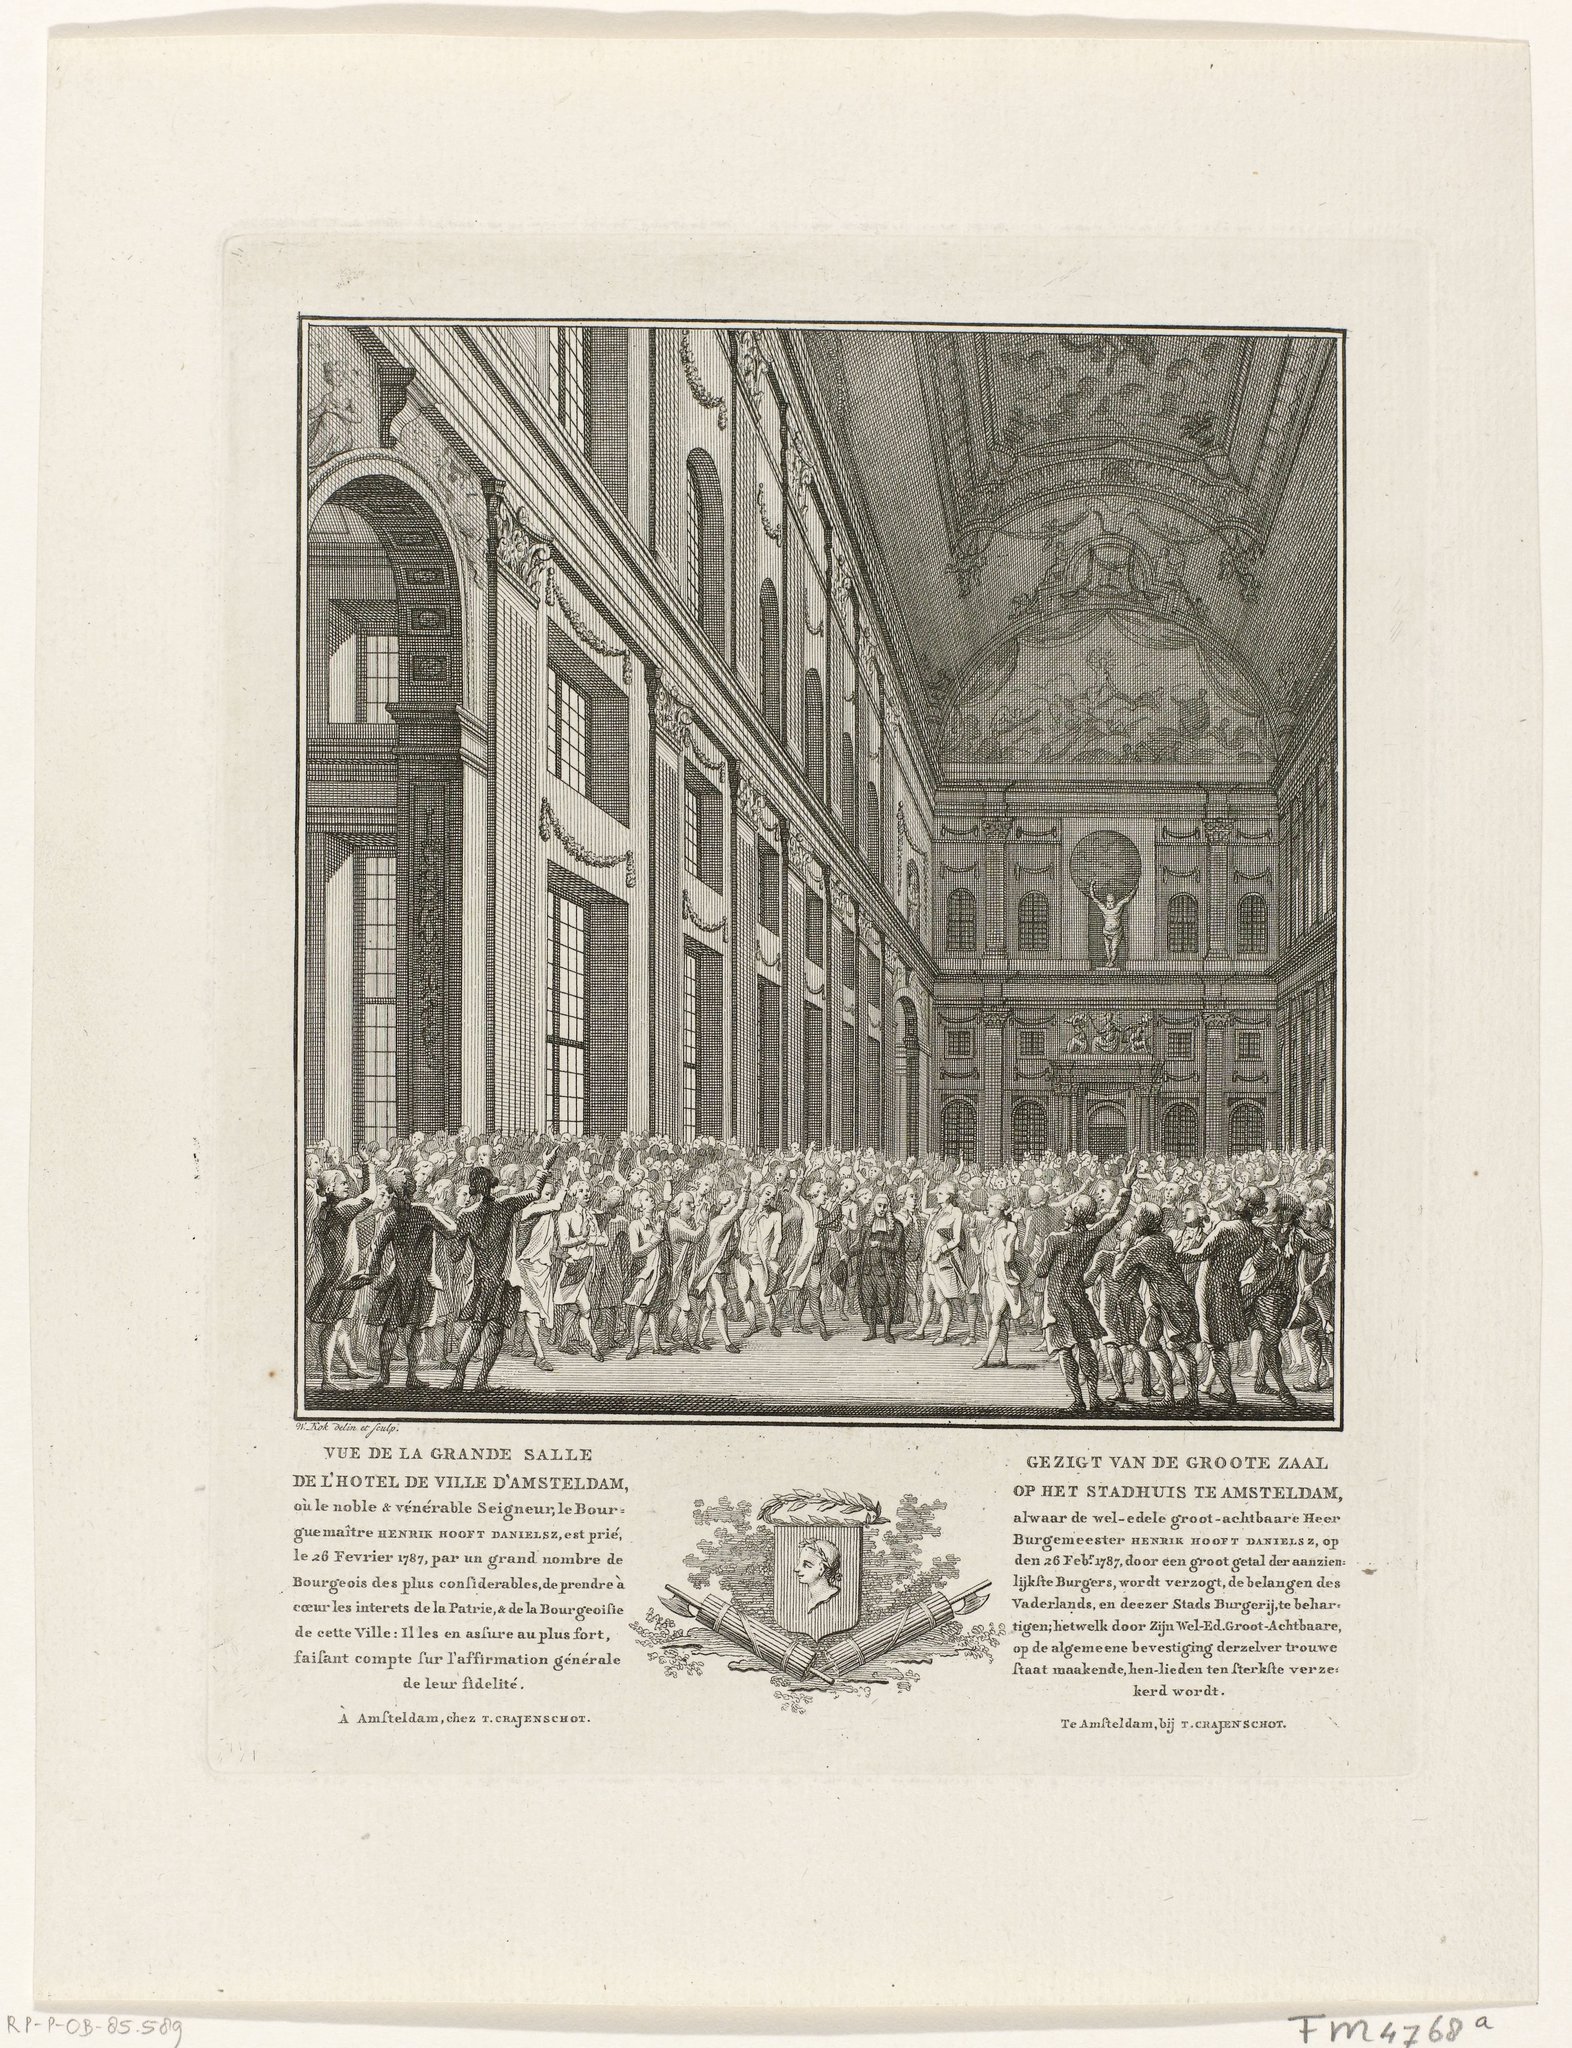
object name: print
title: Vue de la Grande Salle de l'Hotel de Ville d'Amsterdam / Gezigt van de Groote Zaal op het Stadhuis te Amsterdam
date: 1787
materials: paper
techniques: engraving, etching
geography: northern netherlands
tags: amsterdam, mayor, hendrik danielsz. hooft, crowd, mob, mayor, burgomaster, person addressing a group, orator, patriots (1780-1795)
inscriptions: collector's mark: Lugt 2228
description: De Amsterdamse burgemeester Hendrik Danielsz. Hooft spreekt in de Burgerzaal van het Stadhuis de samengestroomde burgers toe en verzekert hen de belangen van de stad en het vaderland te zulllen verdedigen, 26 februari 1787. In de marge de titels in het Frans en Nederlands aan weerszijden van het wapen van Hooft.